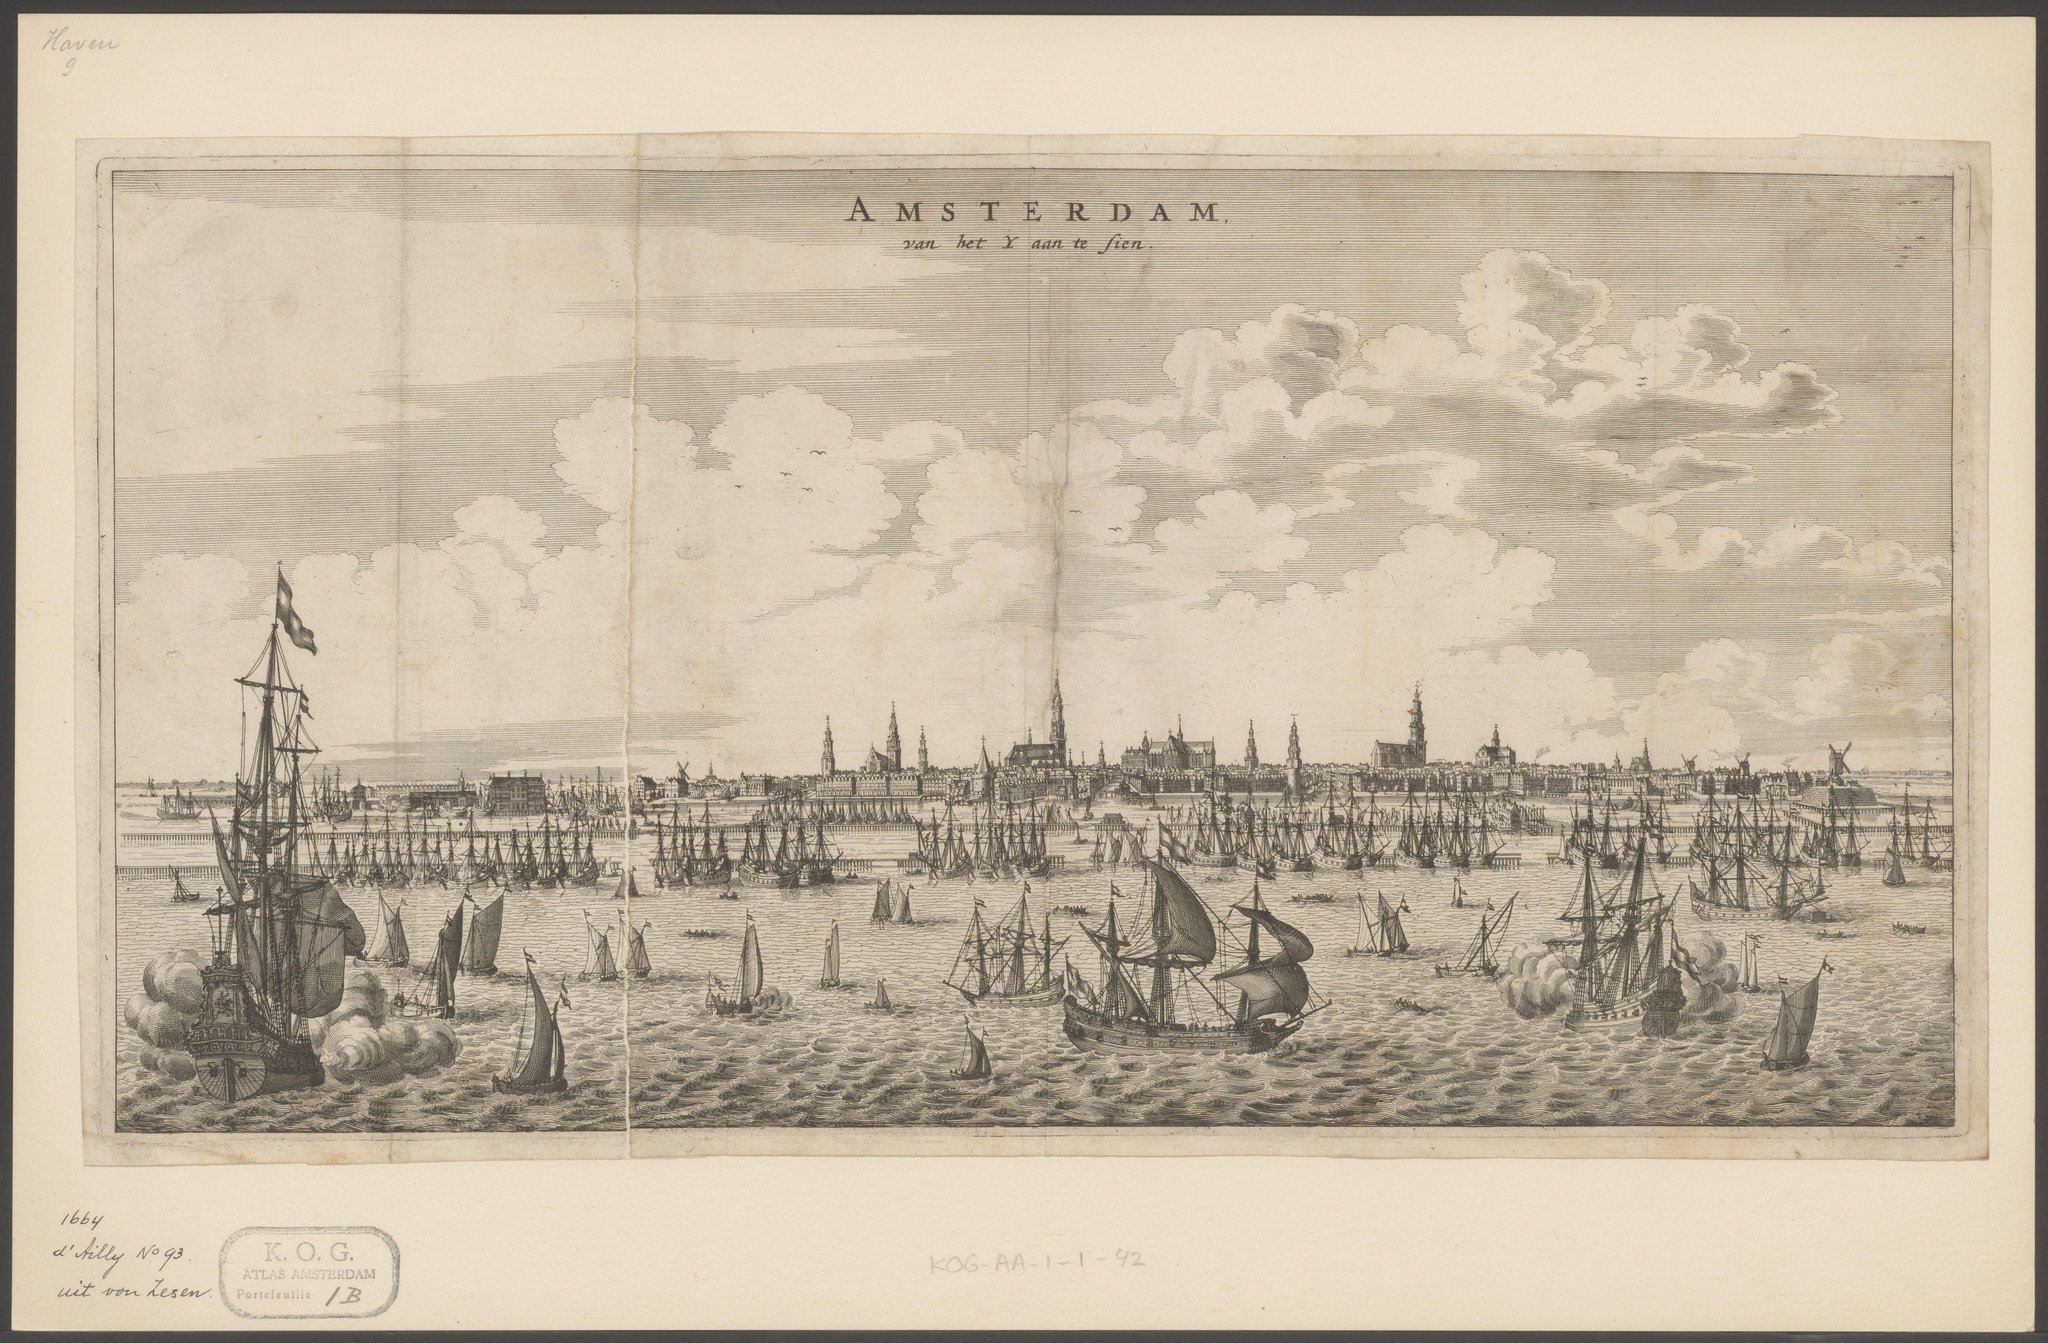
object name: print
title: Amsterdam van het Y aan te sien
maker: jacob van meurs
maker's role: draughtsman, print maker, publisher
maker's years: 1619-1680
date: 1663-1664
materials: paper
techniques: engraving, etching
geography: amsterdam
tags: city-view in general; 'veduta', river, firearms: cannon, ships (in general) - cc - more than one ship, amsterdam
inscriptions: collector's mark: ‘IB’ Lugt 1641b, inscription: ‘1664 / d'Ailly No 93 / uit von Zesen’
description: Prent ook gebruikt in: Dapper, Olfert. Historische beschryving der stadt Amsterdam: waer in de voornaemste geschiedenissen (na een kort verhael van gansch Hollant en d'omleggende dorpen (…). Amsterdam: Jacob van Meurs, 1663. En in: Zesen, Philipp von. Beschreibung der Stadt Amsterdam: darinnen von derselben ersten Ursprunge bis auf gegenwärtigen Zustand (…). Amsterdam: Joachim Nosche, 1664. Later aangebrachte datering onder prent is onjuist.